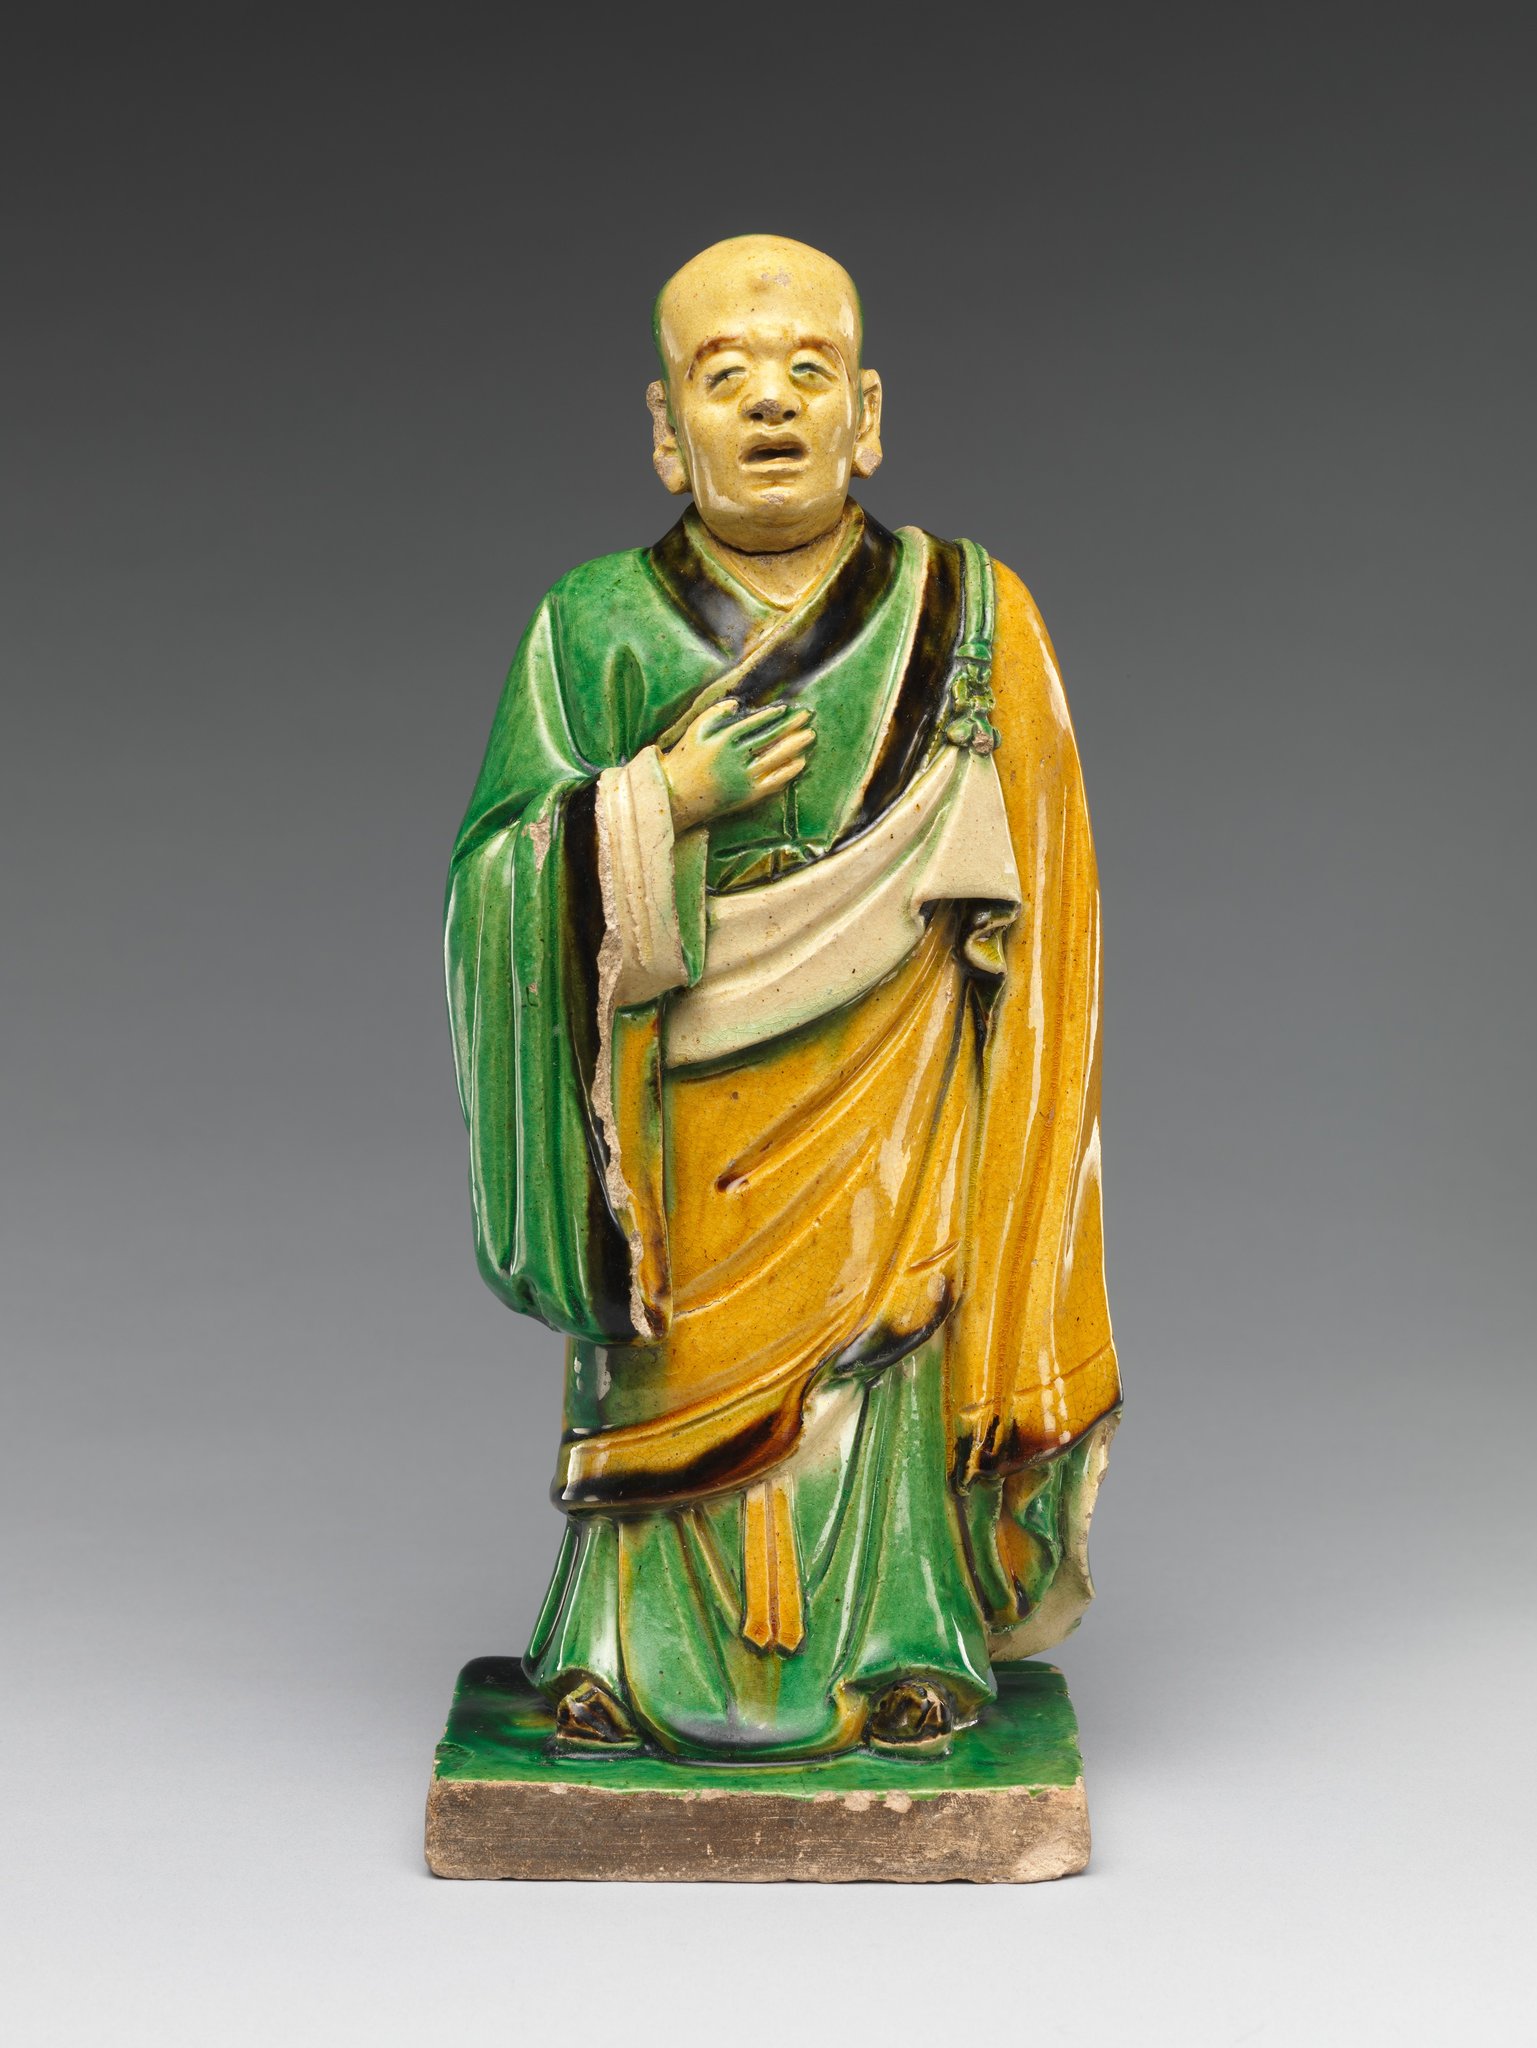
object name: figure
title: Par nirvana (death and transcendence of the Buddha) and attendant arhats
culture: chinese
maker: qiao bin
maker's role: artist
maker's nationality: chinese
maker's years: 1481-1507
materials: earthenware, glaze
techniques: polychrome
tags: men